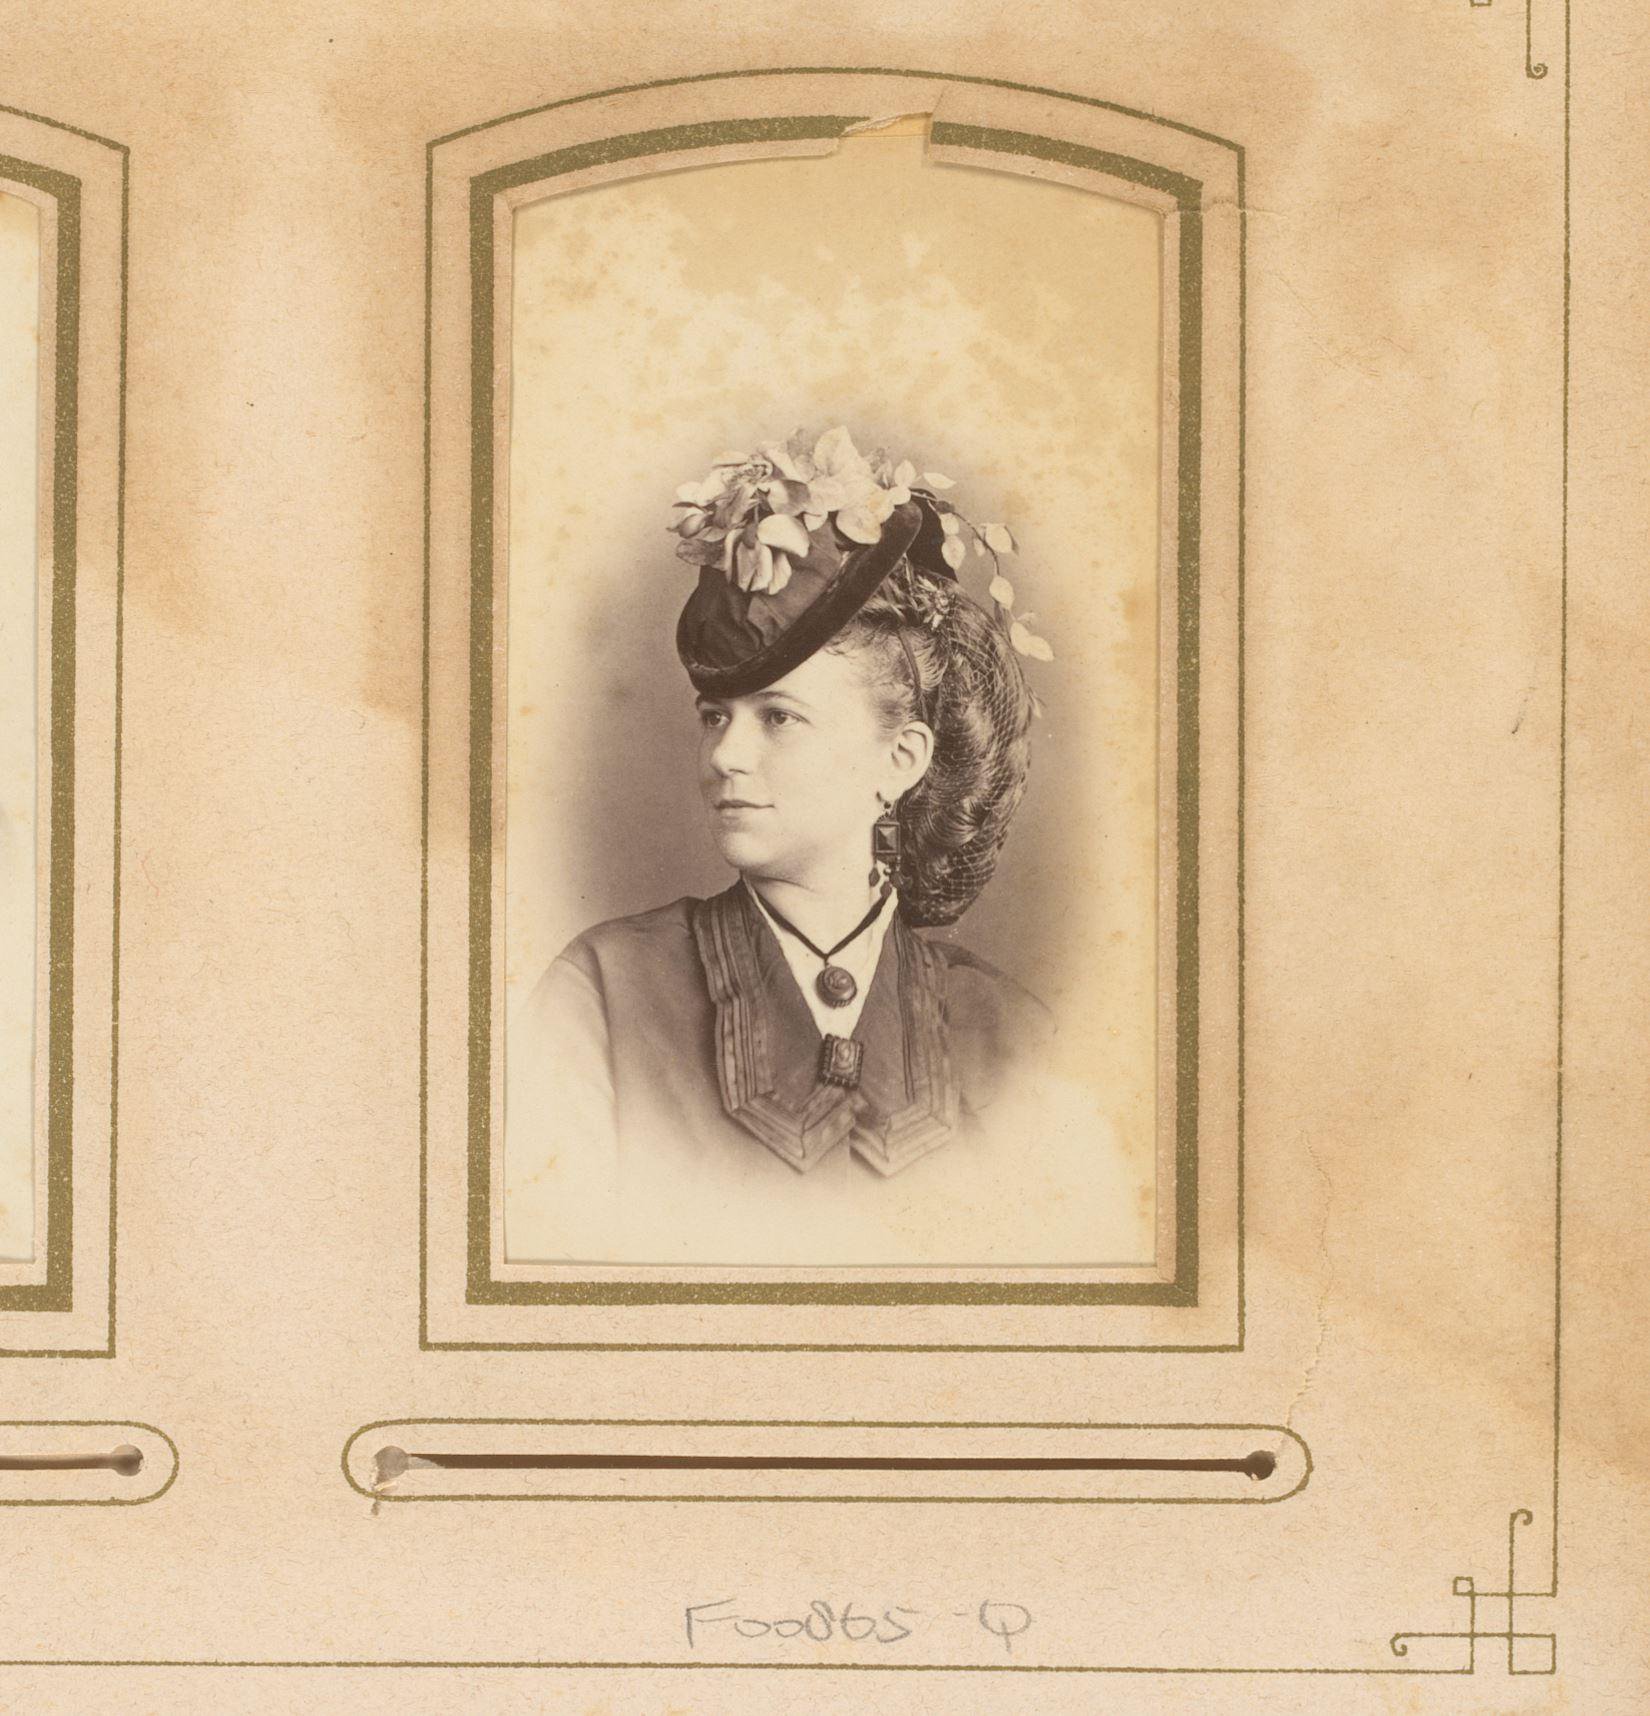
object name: photograph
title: Portret van een vrouw met hoed en haarnet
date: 1874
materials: cardboard, photographic support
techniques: albumen print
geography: batavia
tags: historical persons - bb - woman, head-gear: hat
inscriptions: date: ‘2 Maart 1874’, inscription: ‘Atelier/ Petz & Co./ JAVA/ Batavia./ Portretten in elke grootte & genre./ Nabestellingen worden zelfs na/ verloop van jaren geeffectueerd.’